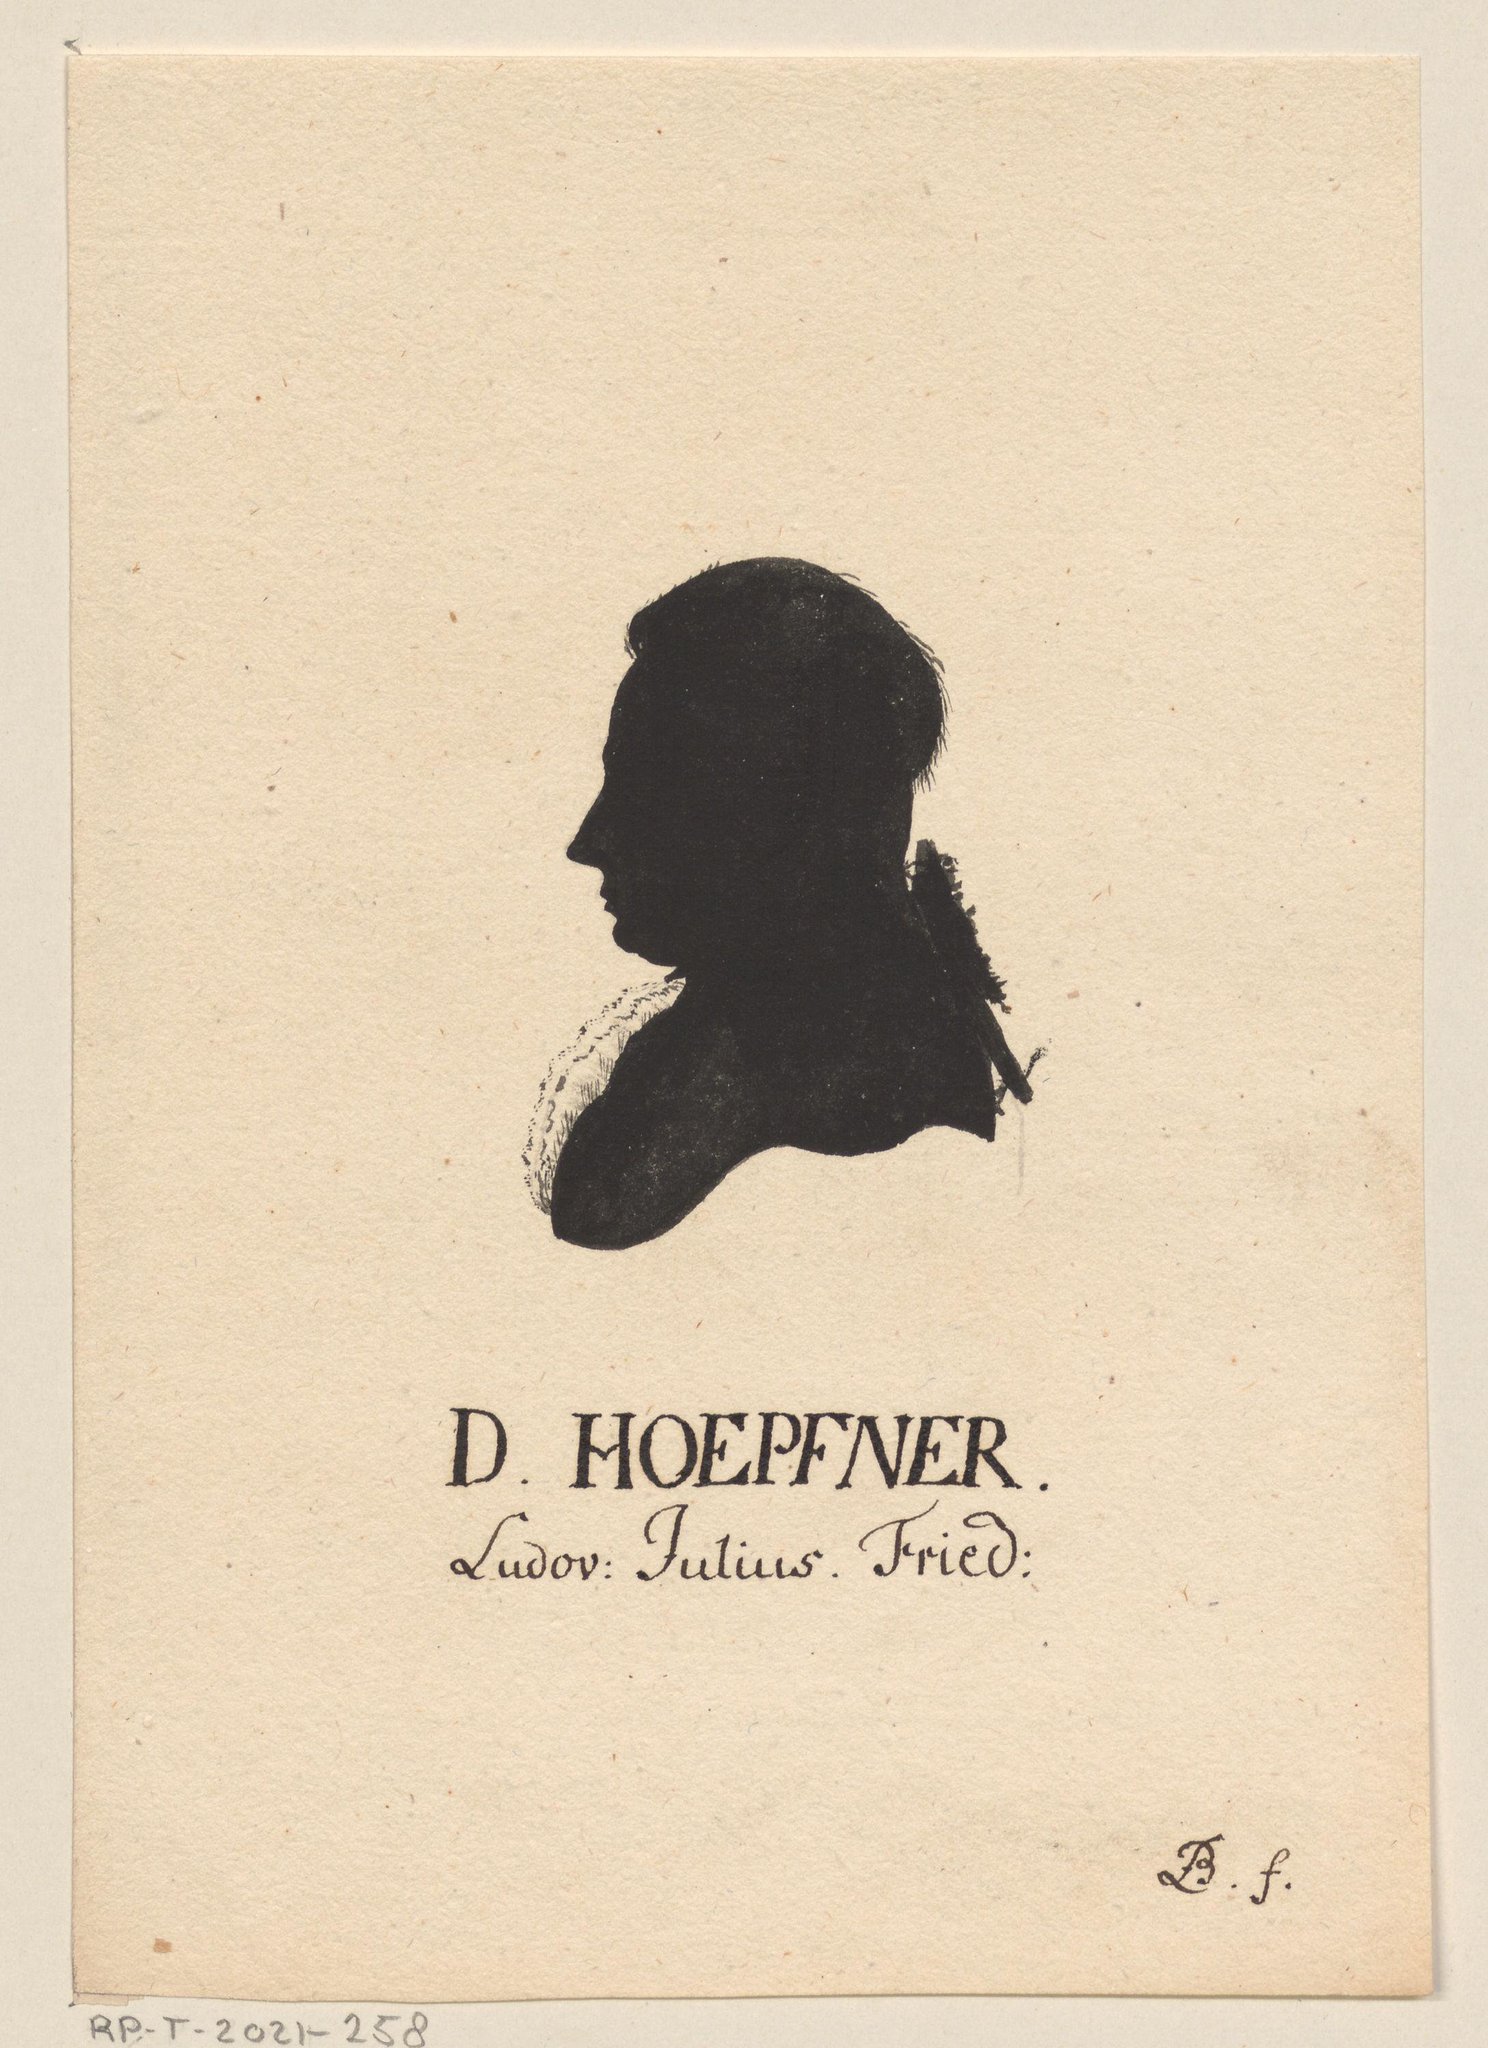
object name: drawing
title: Silhouetportret van Ludwig Höpfner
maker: Anonymous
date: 1775-1799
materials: ink, paper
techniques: pen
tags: historical persons